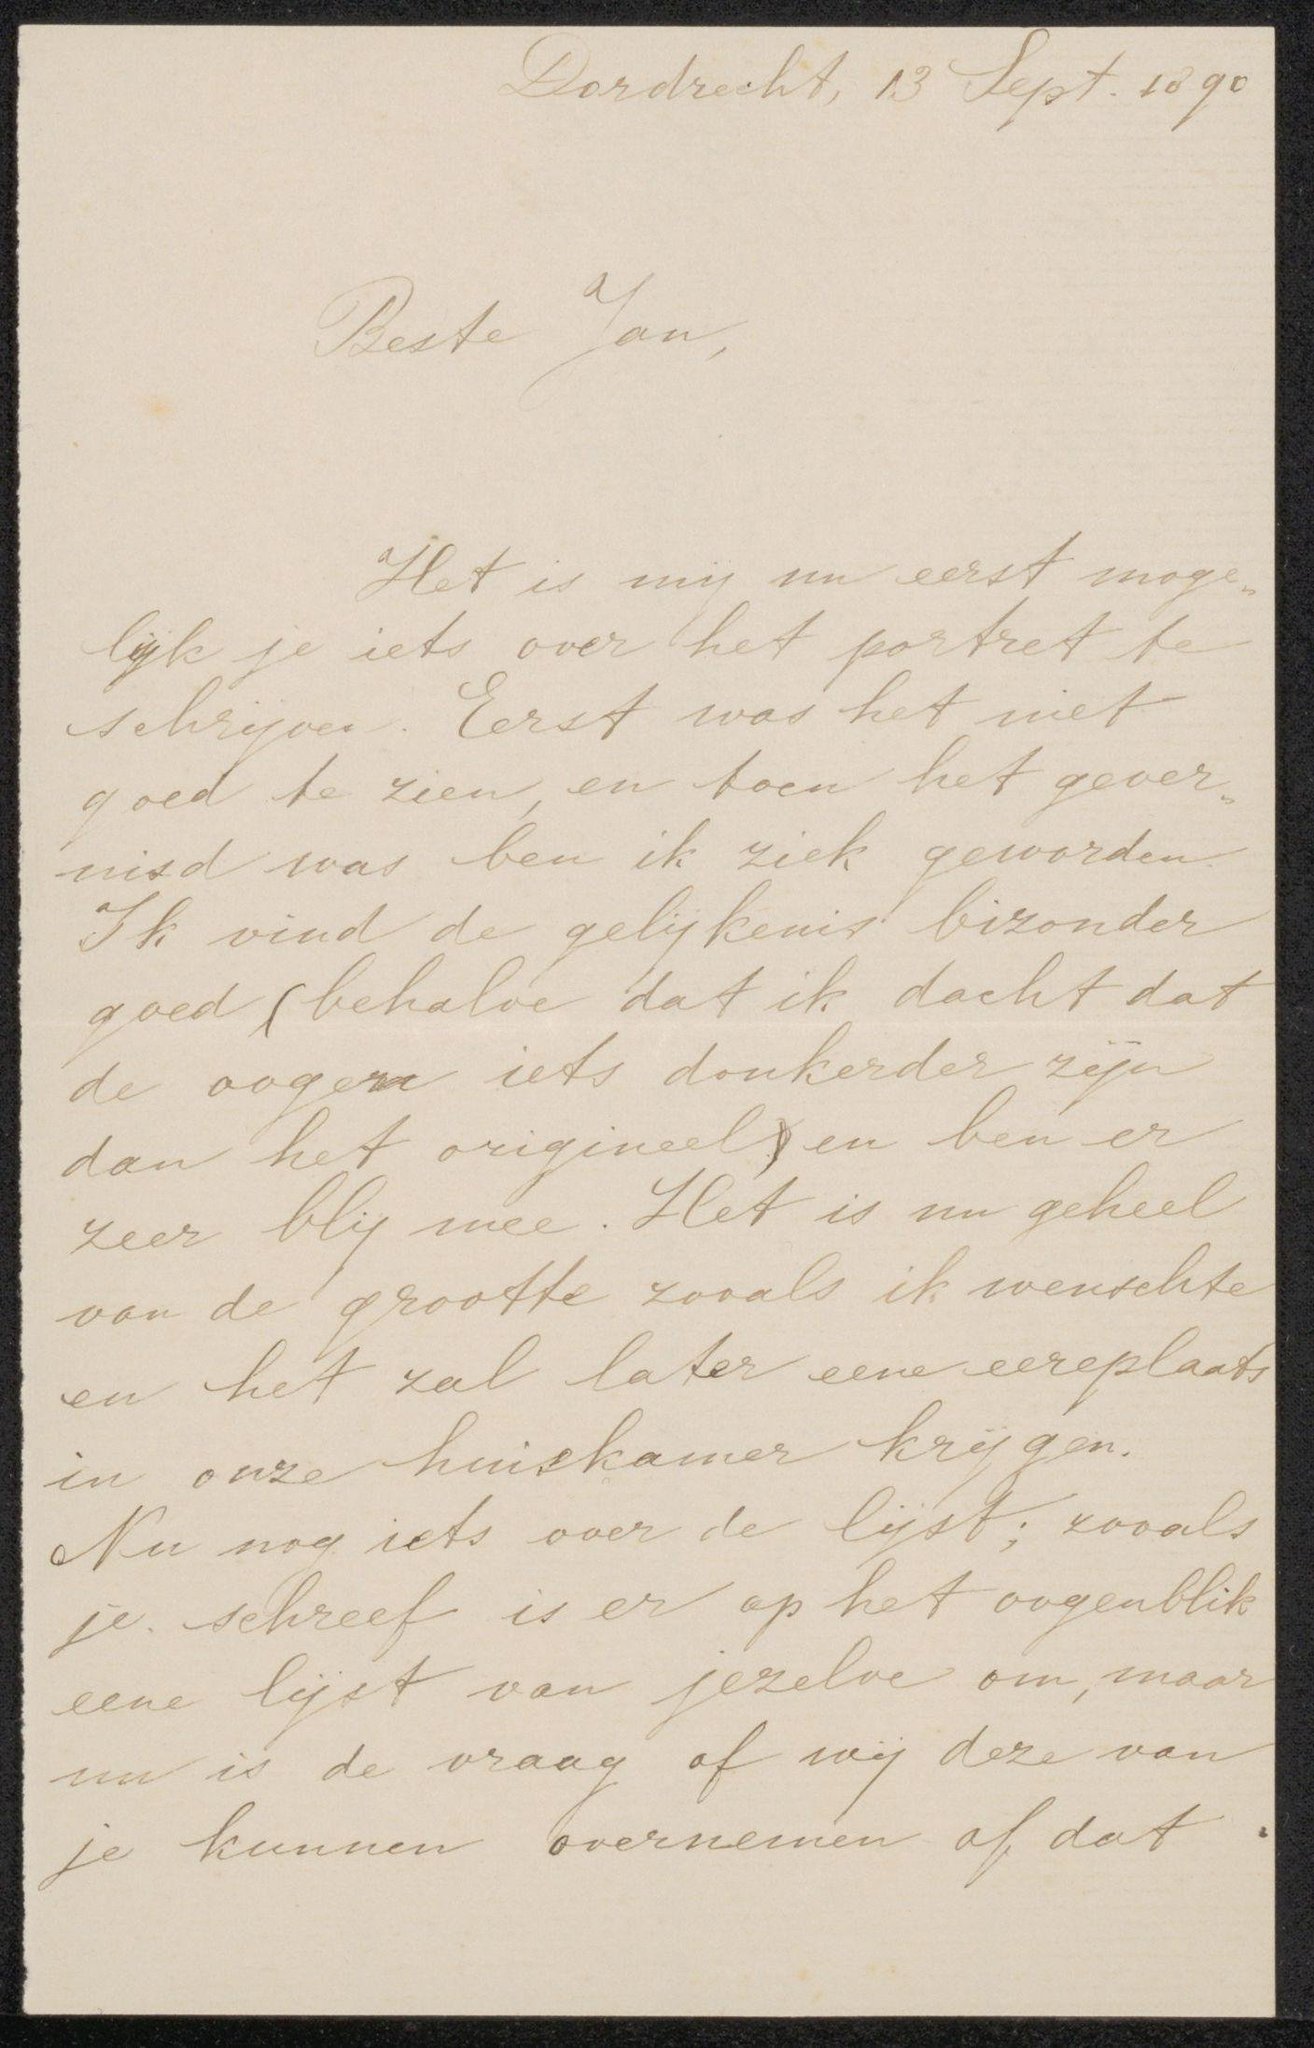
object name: letter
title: Brief aan Jan Veth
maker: elizabeth lebret-giltay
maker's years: 1845-1936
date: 1890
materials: ink, paper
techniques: pen, writing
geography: dordrecht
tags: dordrecht, amsterdam, painter, print maker, draughtsman, designer, jan veth, historical persons (portraits and scenes from the life)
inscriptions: collector's mark: ‘RPK’